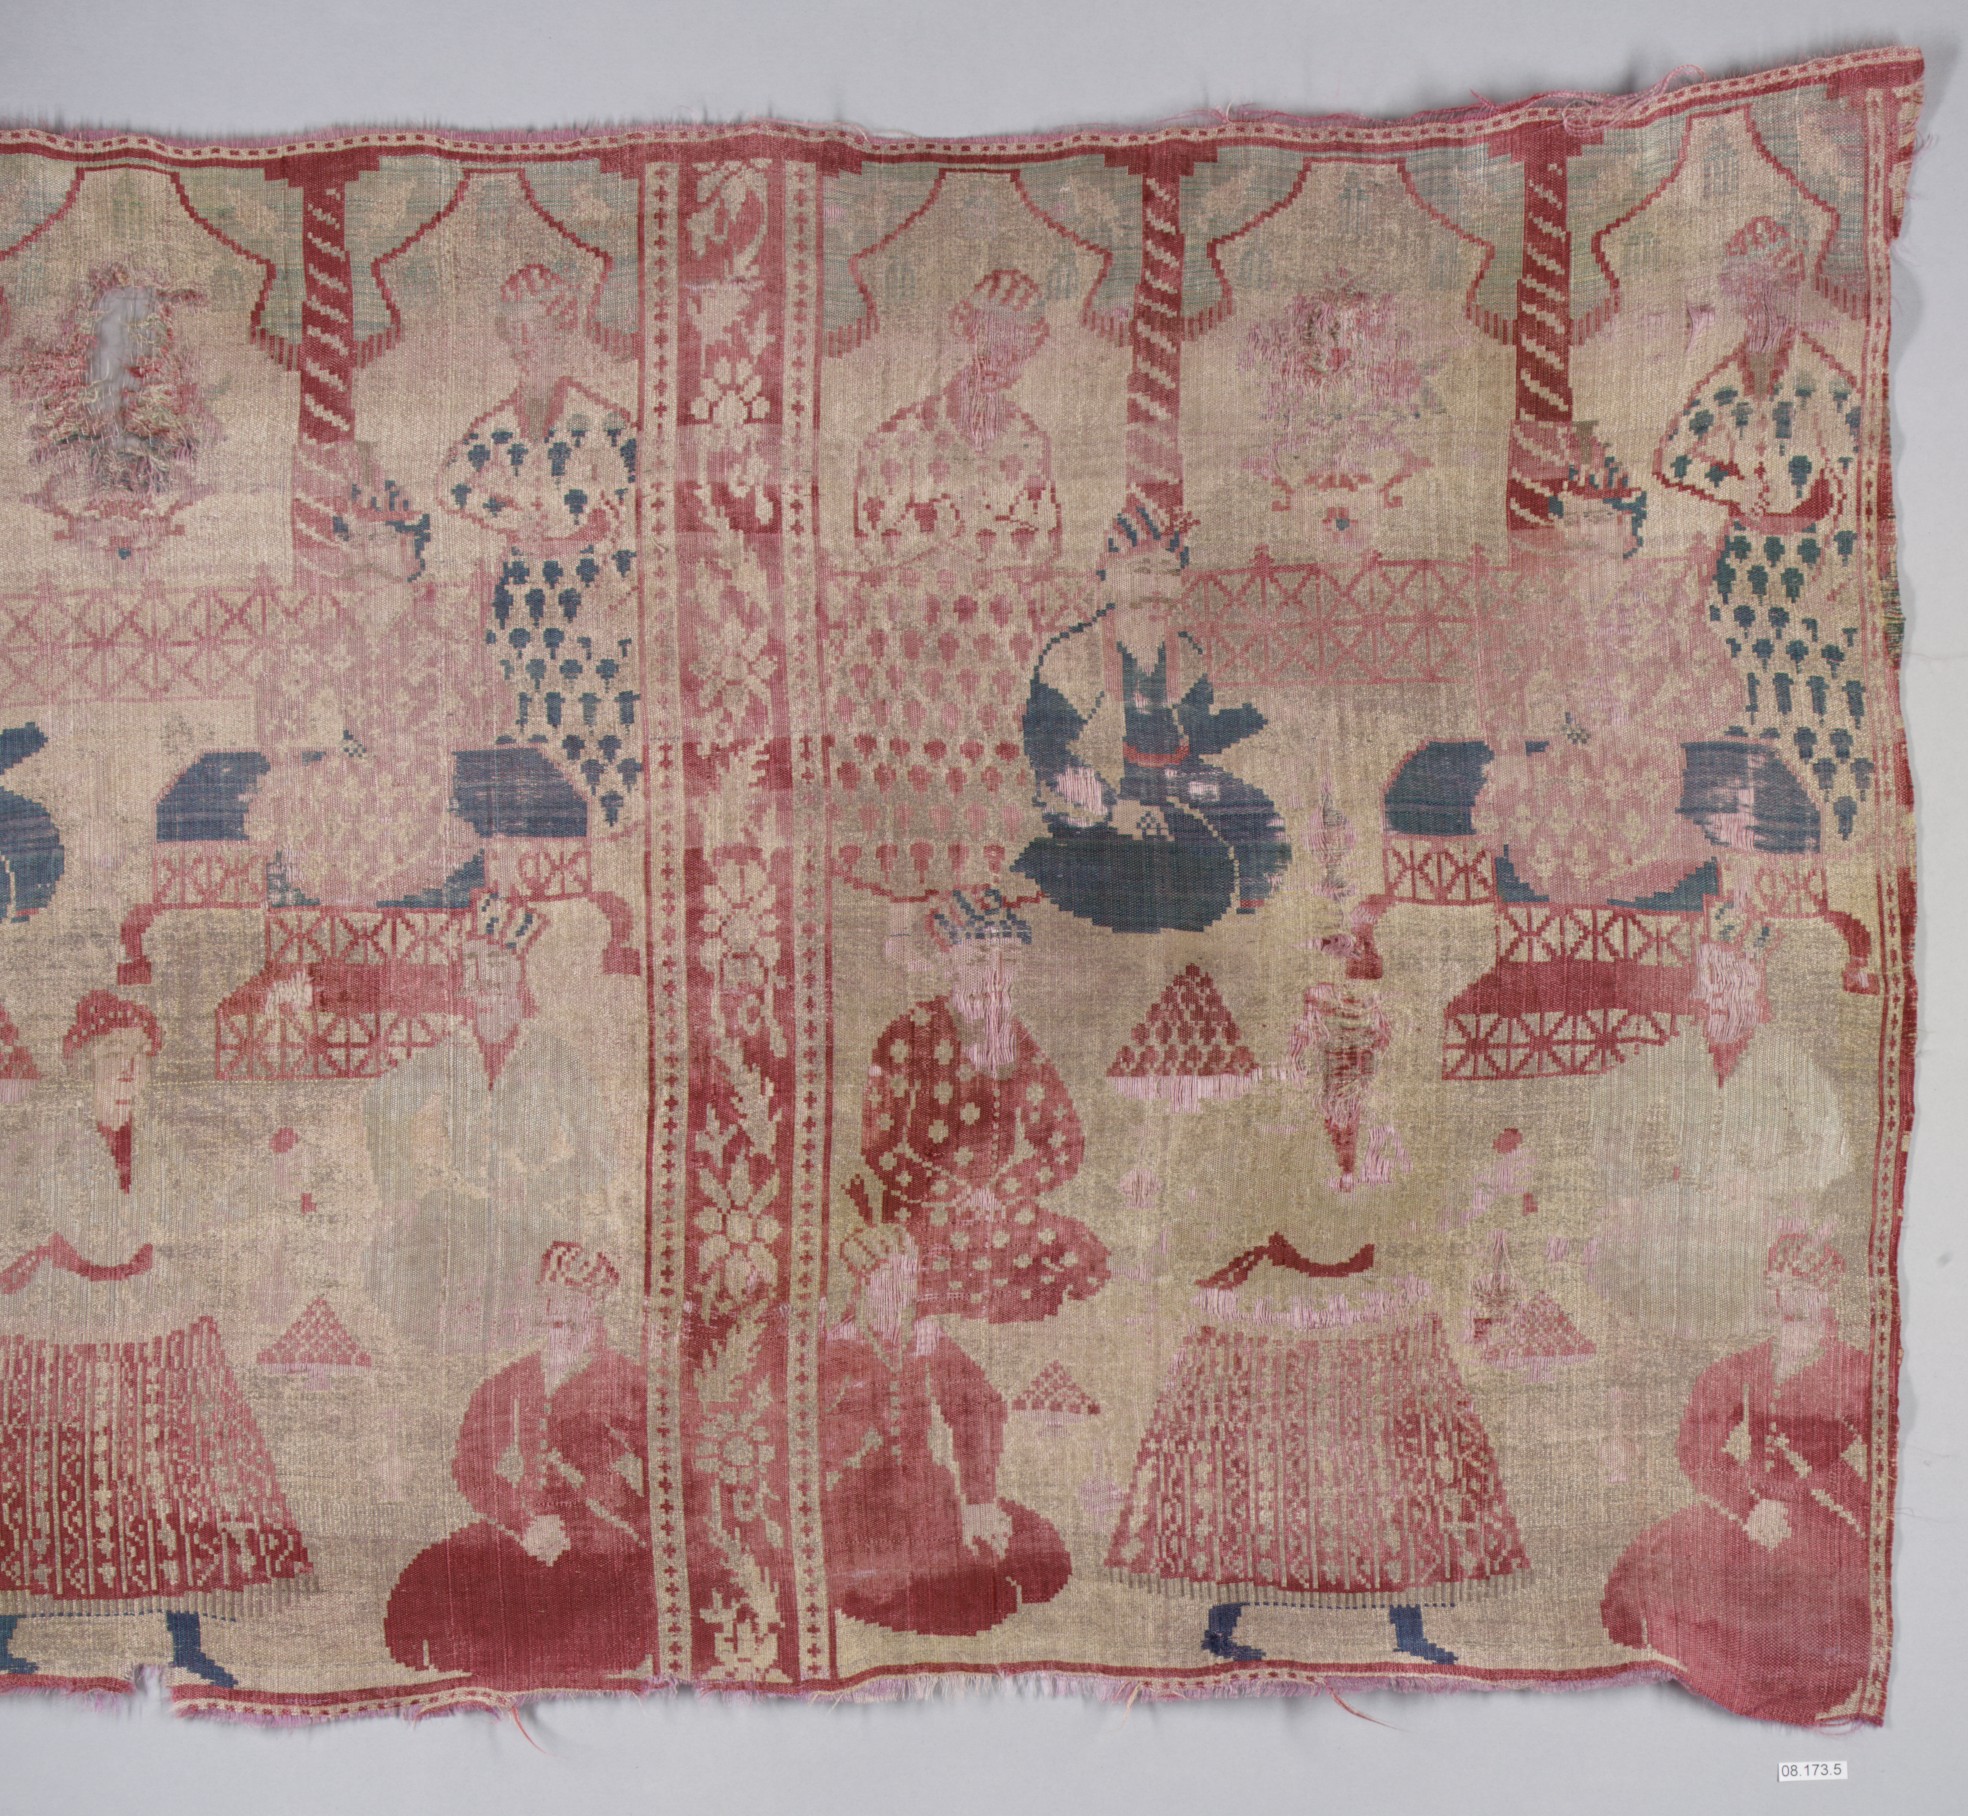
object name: fragment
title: Textile Fragment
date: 1801-1900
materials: metal thread, silk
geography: iran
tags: men